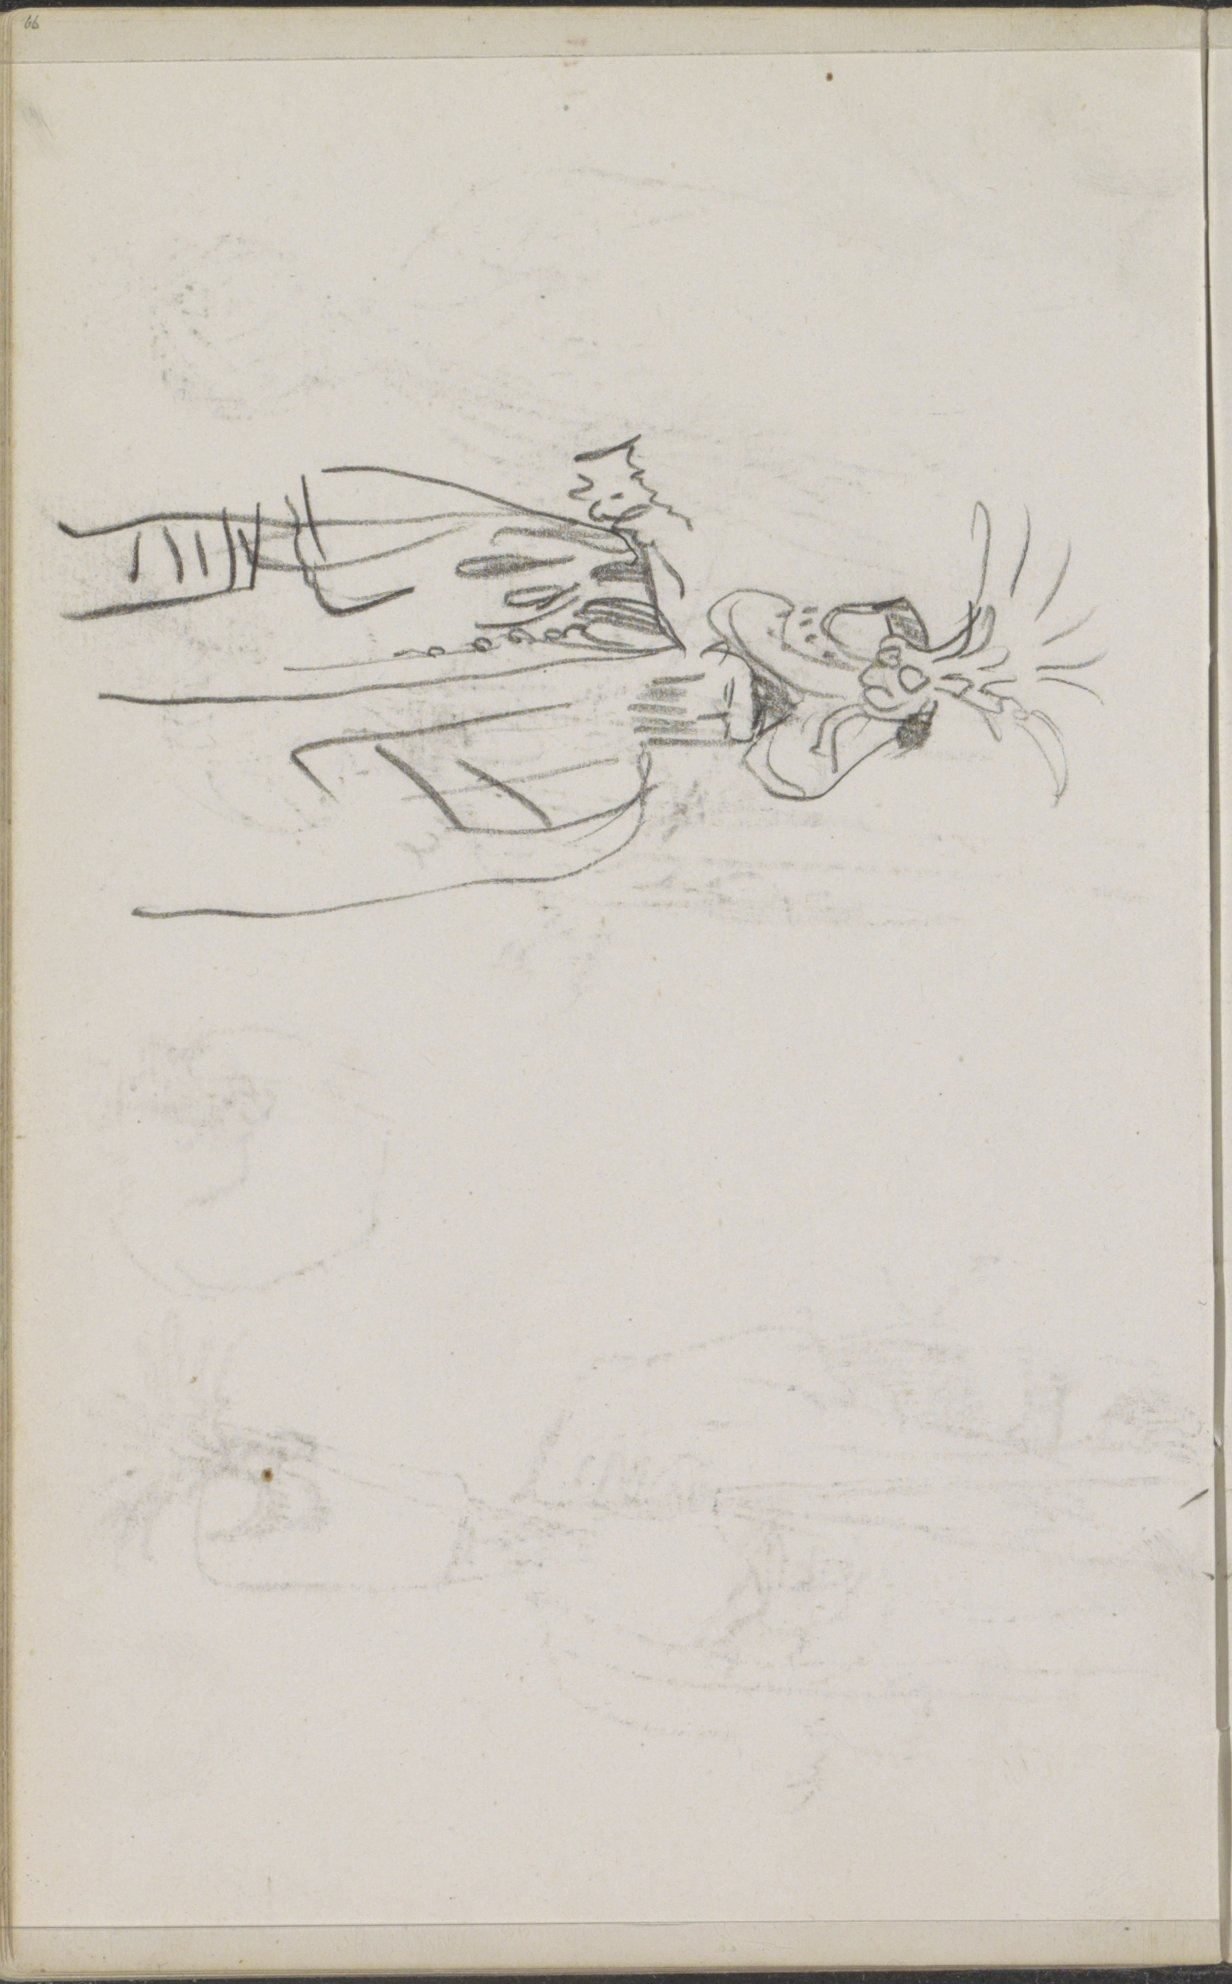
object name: sketchbook leaf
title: Man in oosters kostuum met een hoofddeksel met veren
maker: marius bauer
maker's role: draughtsman, print maker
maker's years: 1867-1932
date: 1896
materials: chalk, paper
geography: turkey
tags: asiatic races and peoples, head-gear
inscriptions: kleurnotitie, handgeschreven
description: Pagina 66 uit een schetsboek met 53 bladen.